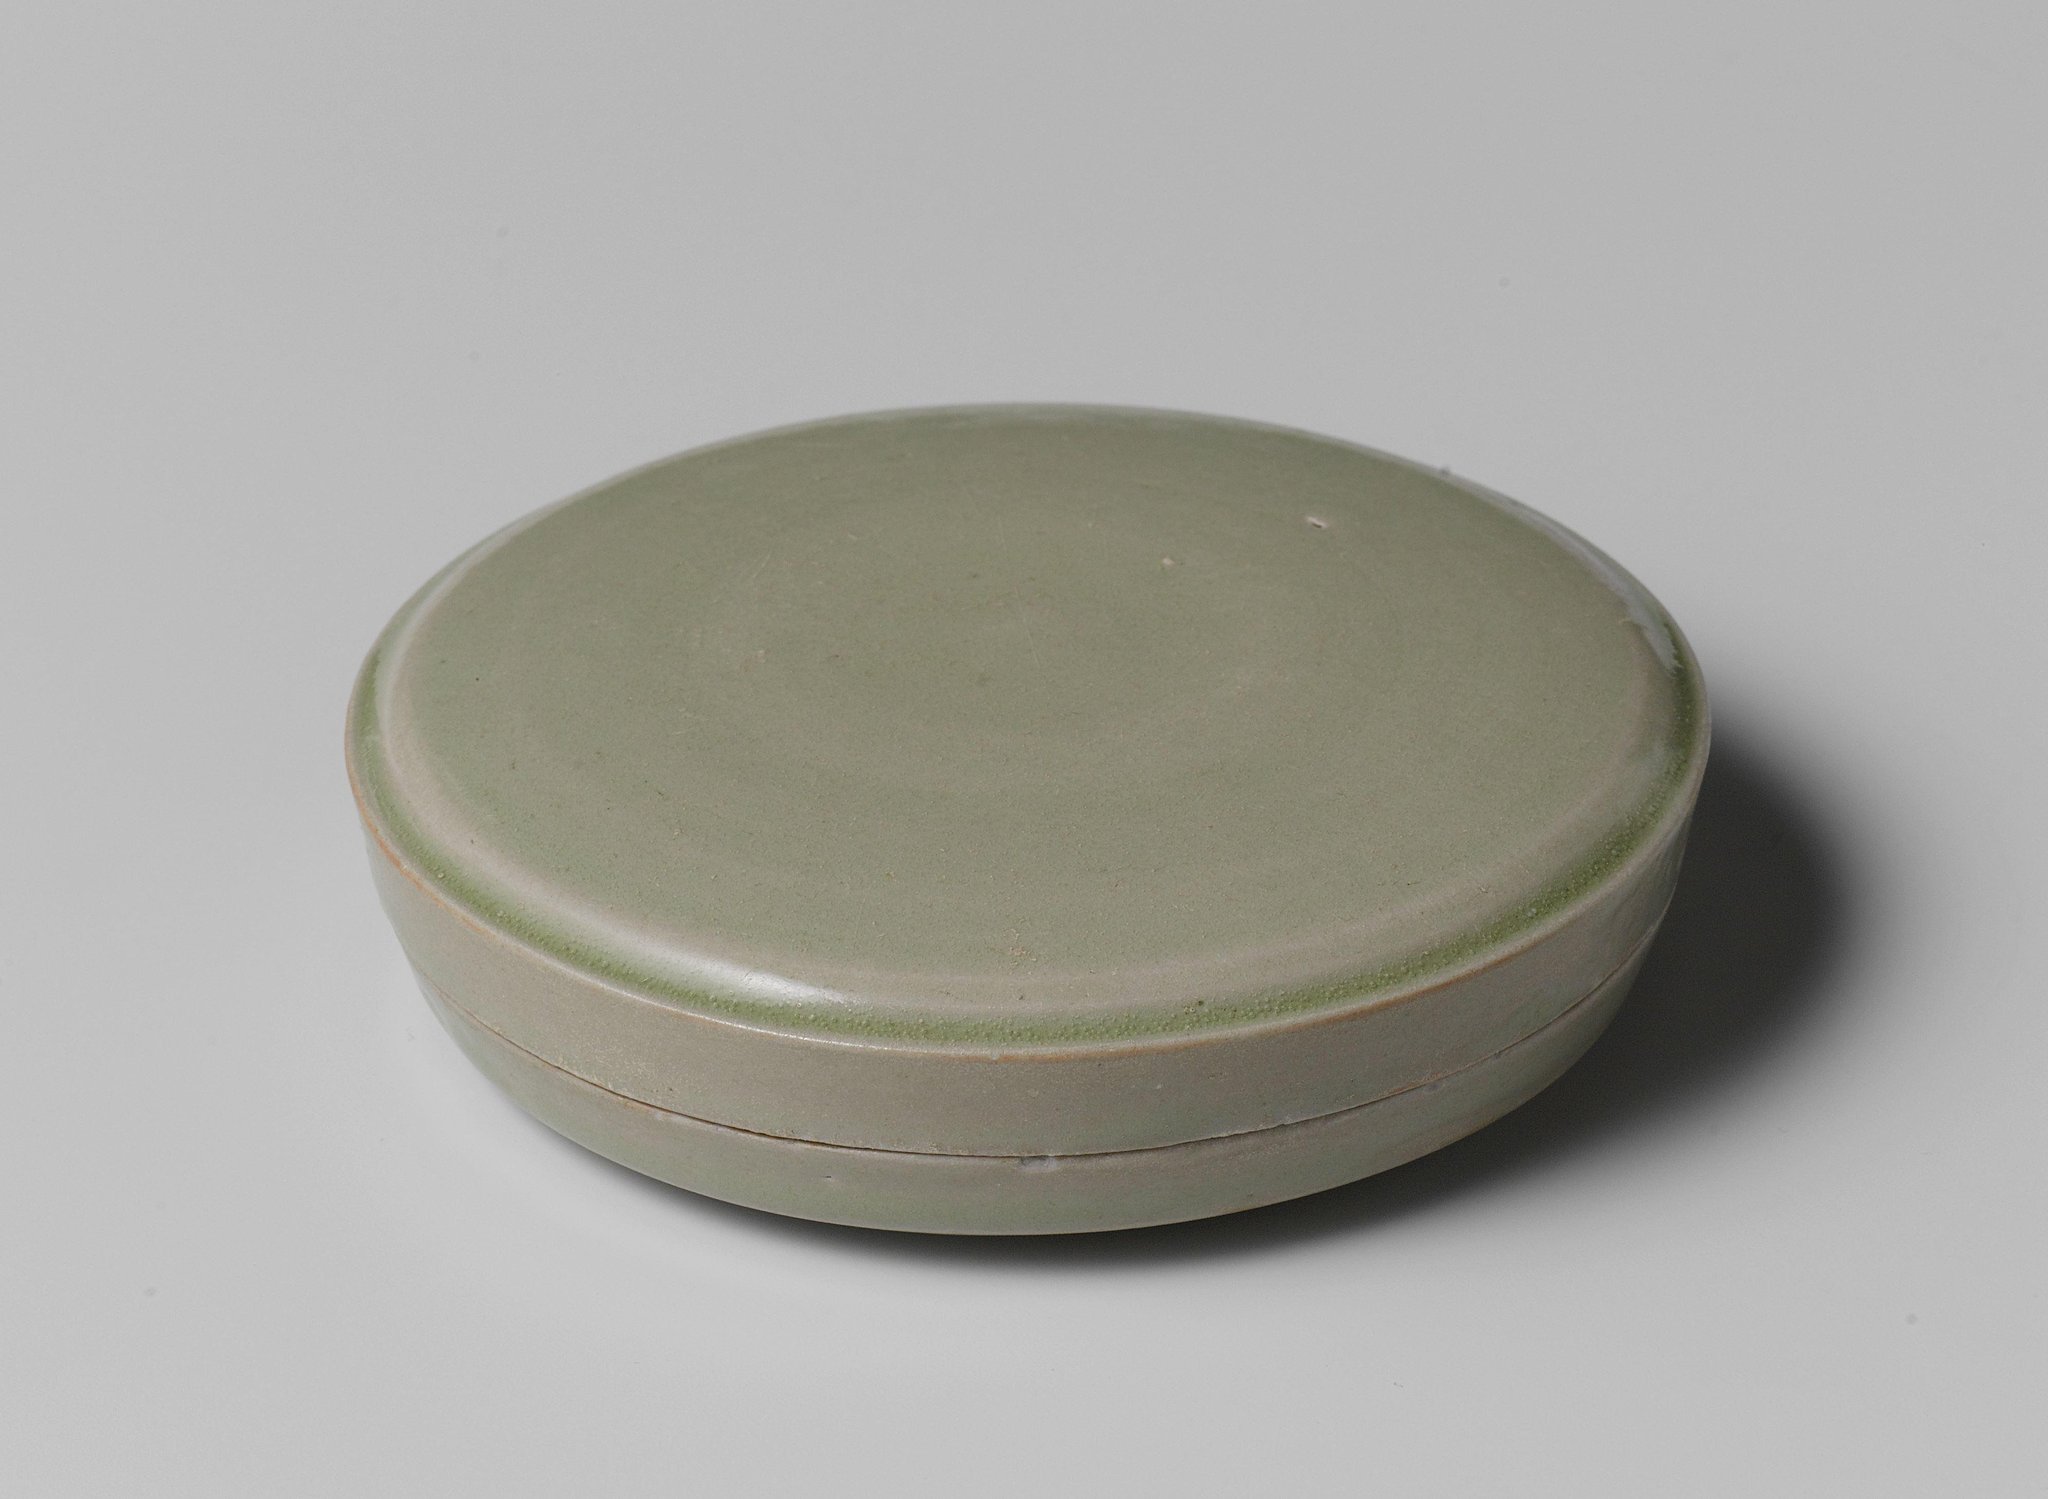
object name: lid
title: Round box with a green glaze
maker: Anonymous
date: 900-999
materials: glaze, stoneware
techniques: firing, turning, vitrification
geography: china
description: Deksel van ronde doos van steengoed, bedekt met een groen glazuur. Celadon (Yue).